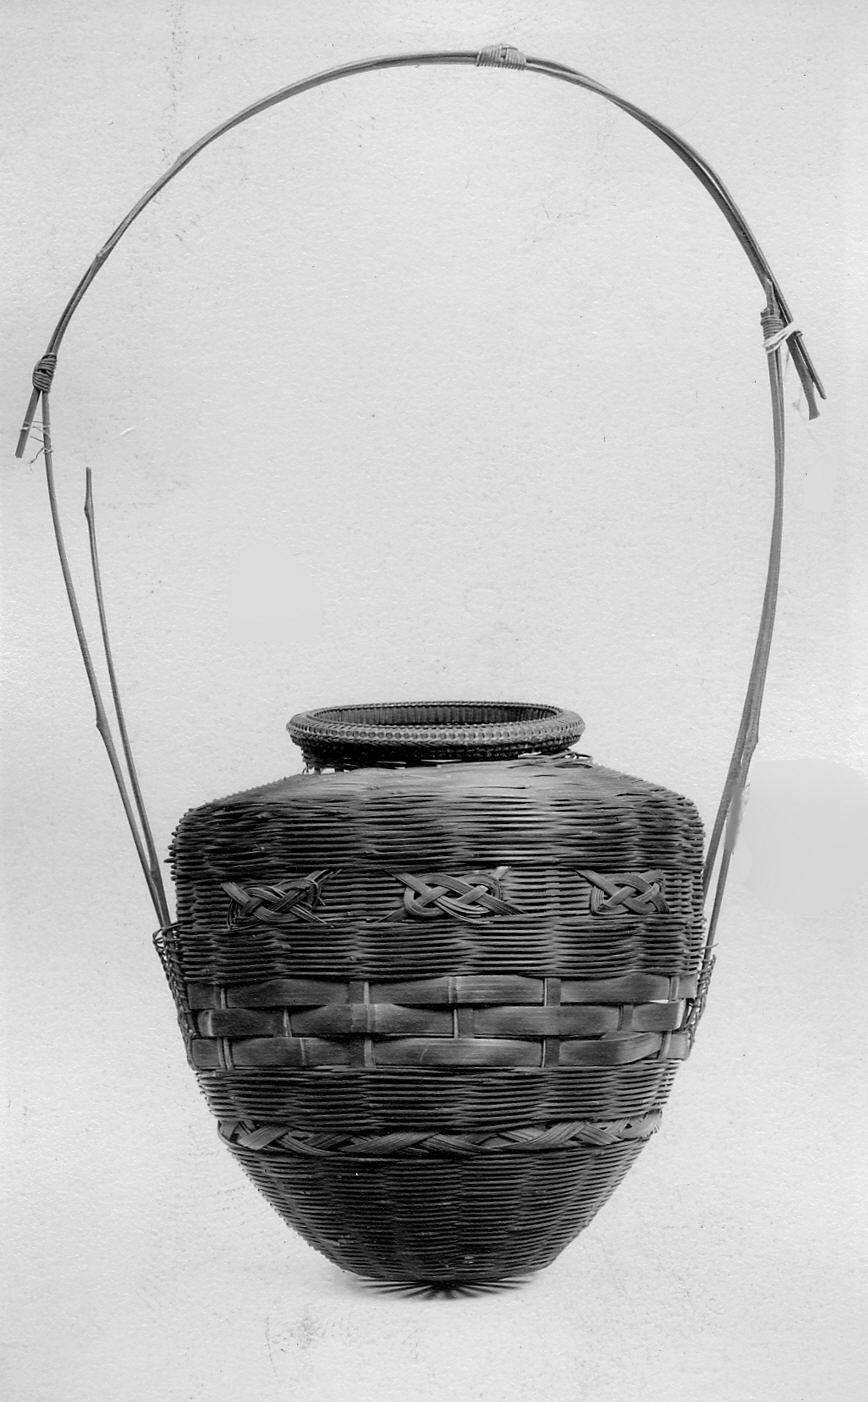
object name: basket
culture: japanese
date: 1801-1900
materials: bamboo